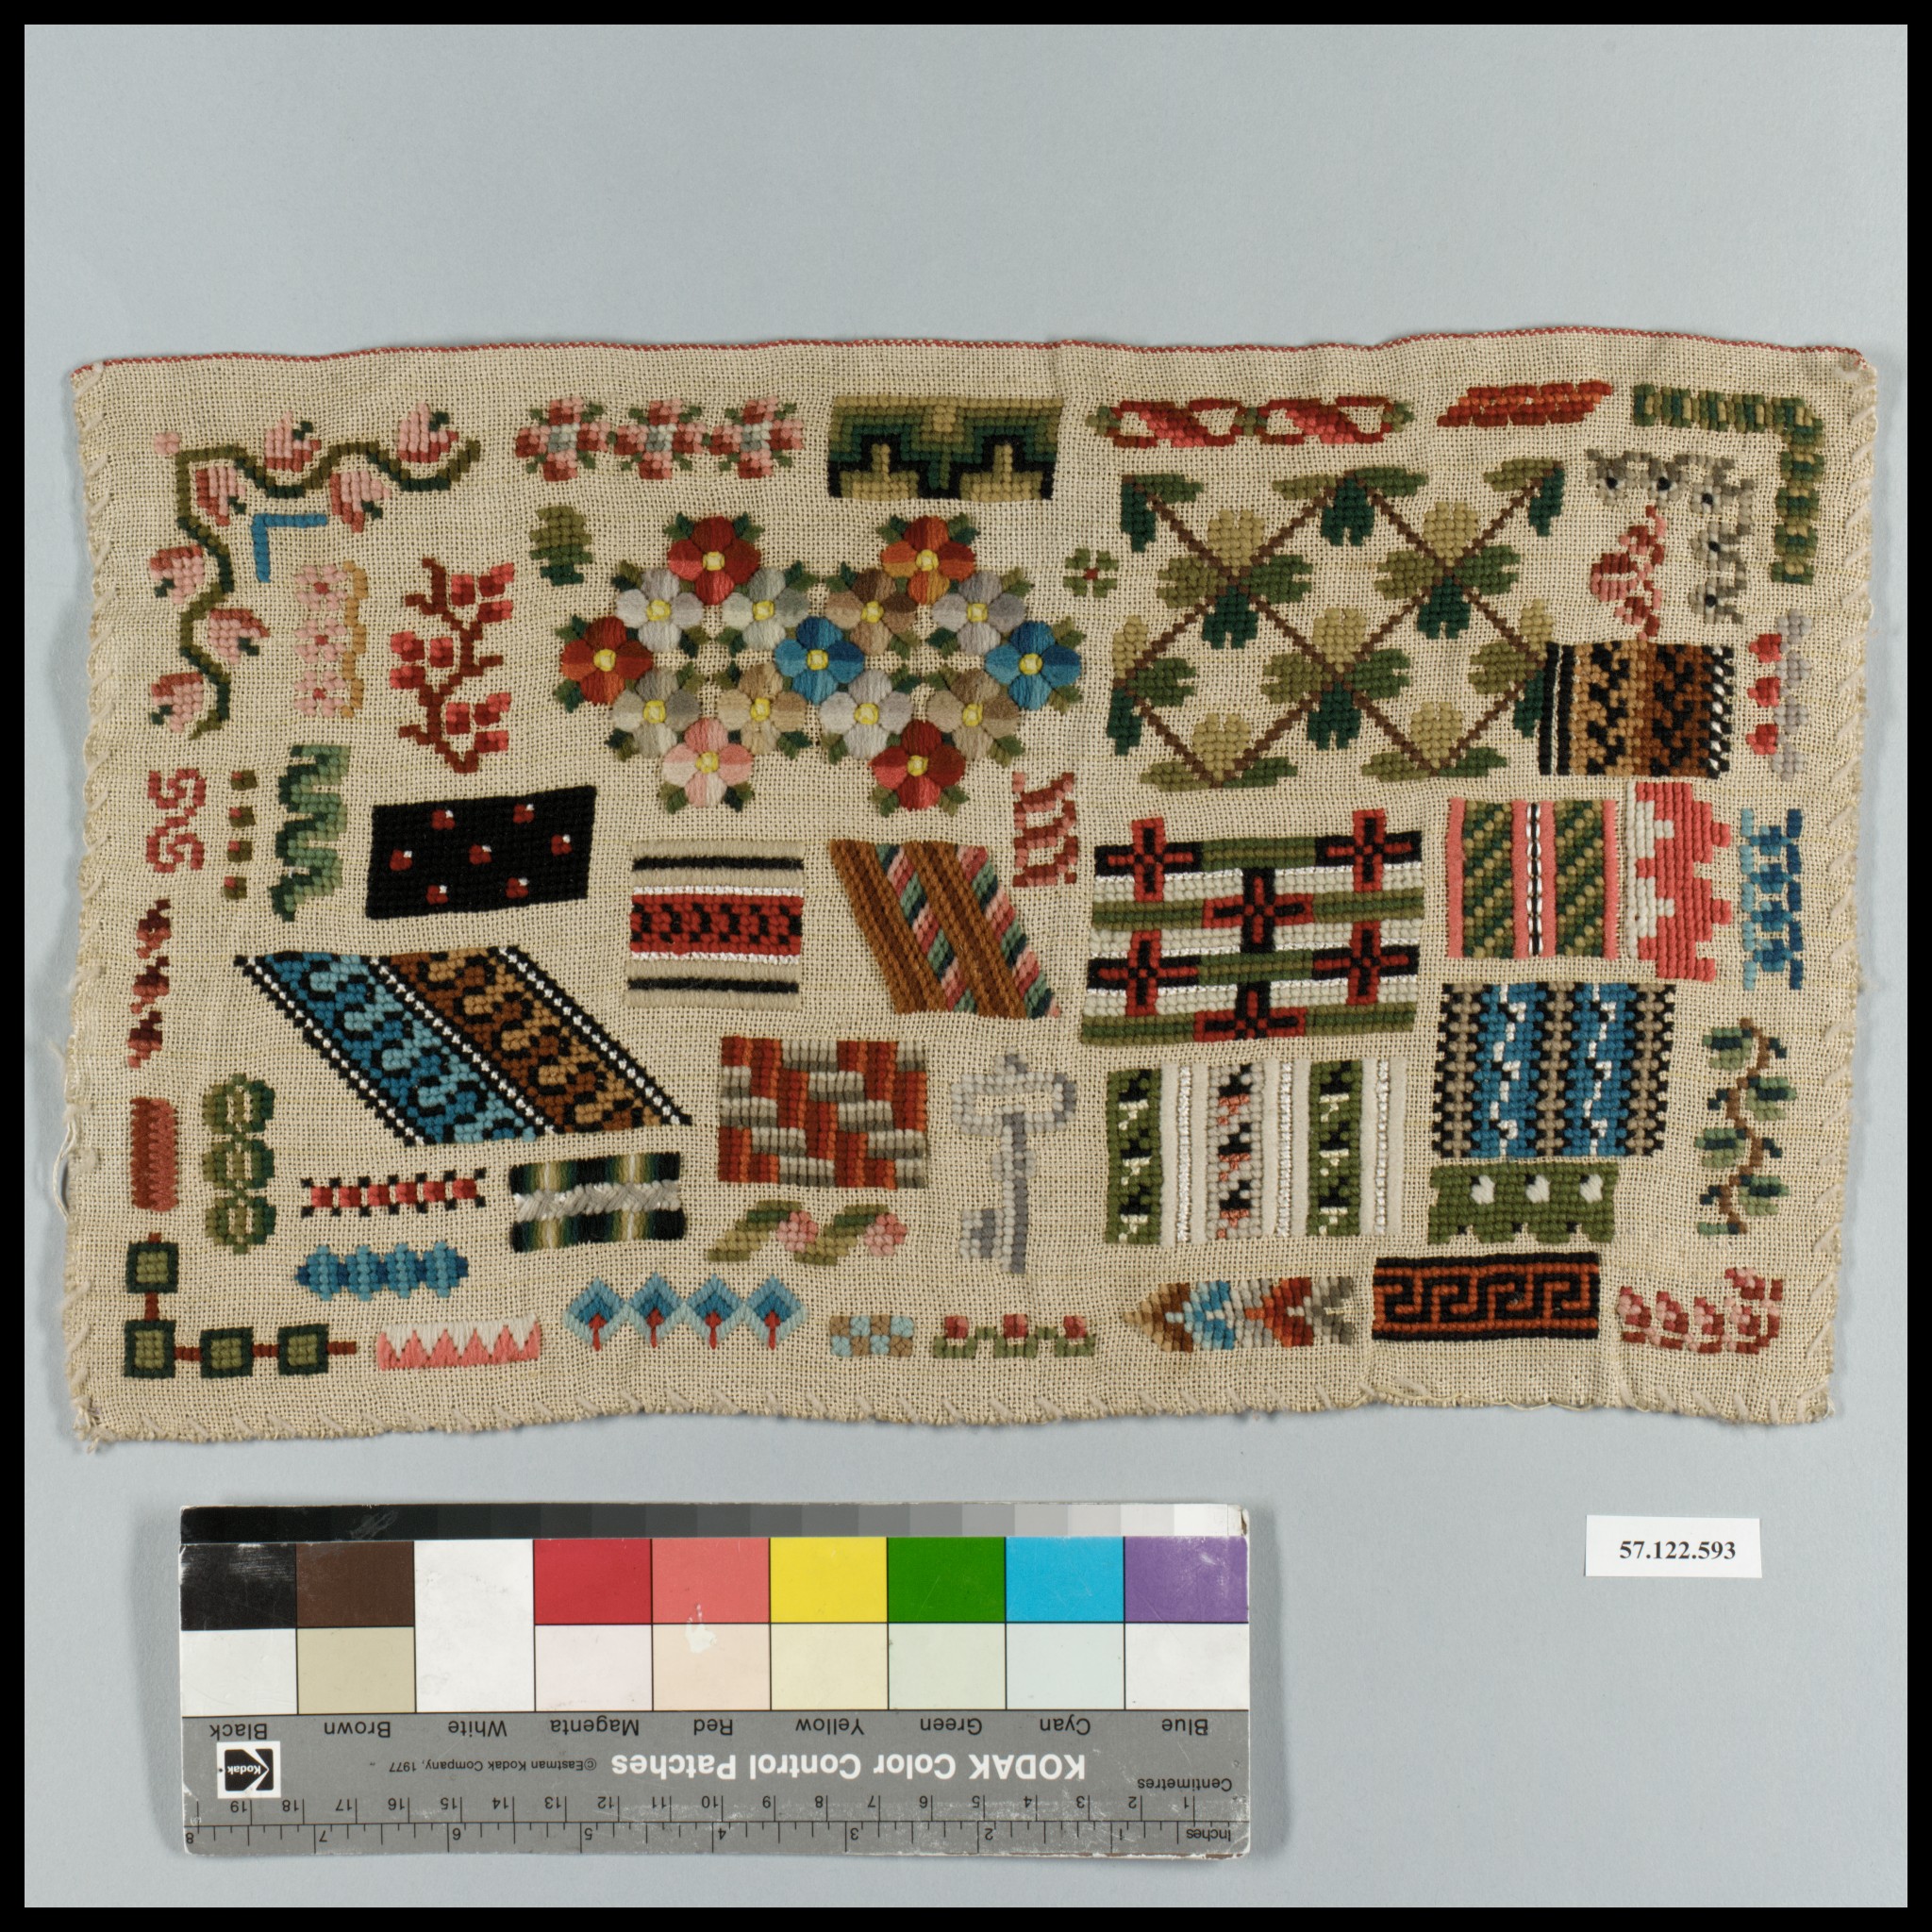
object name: sampler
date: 1801-1900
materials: canvas, cotton, silk, wool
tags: flowers